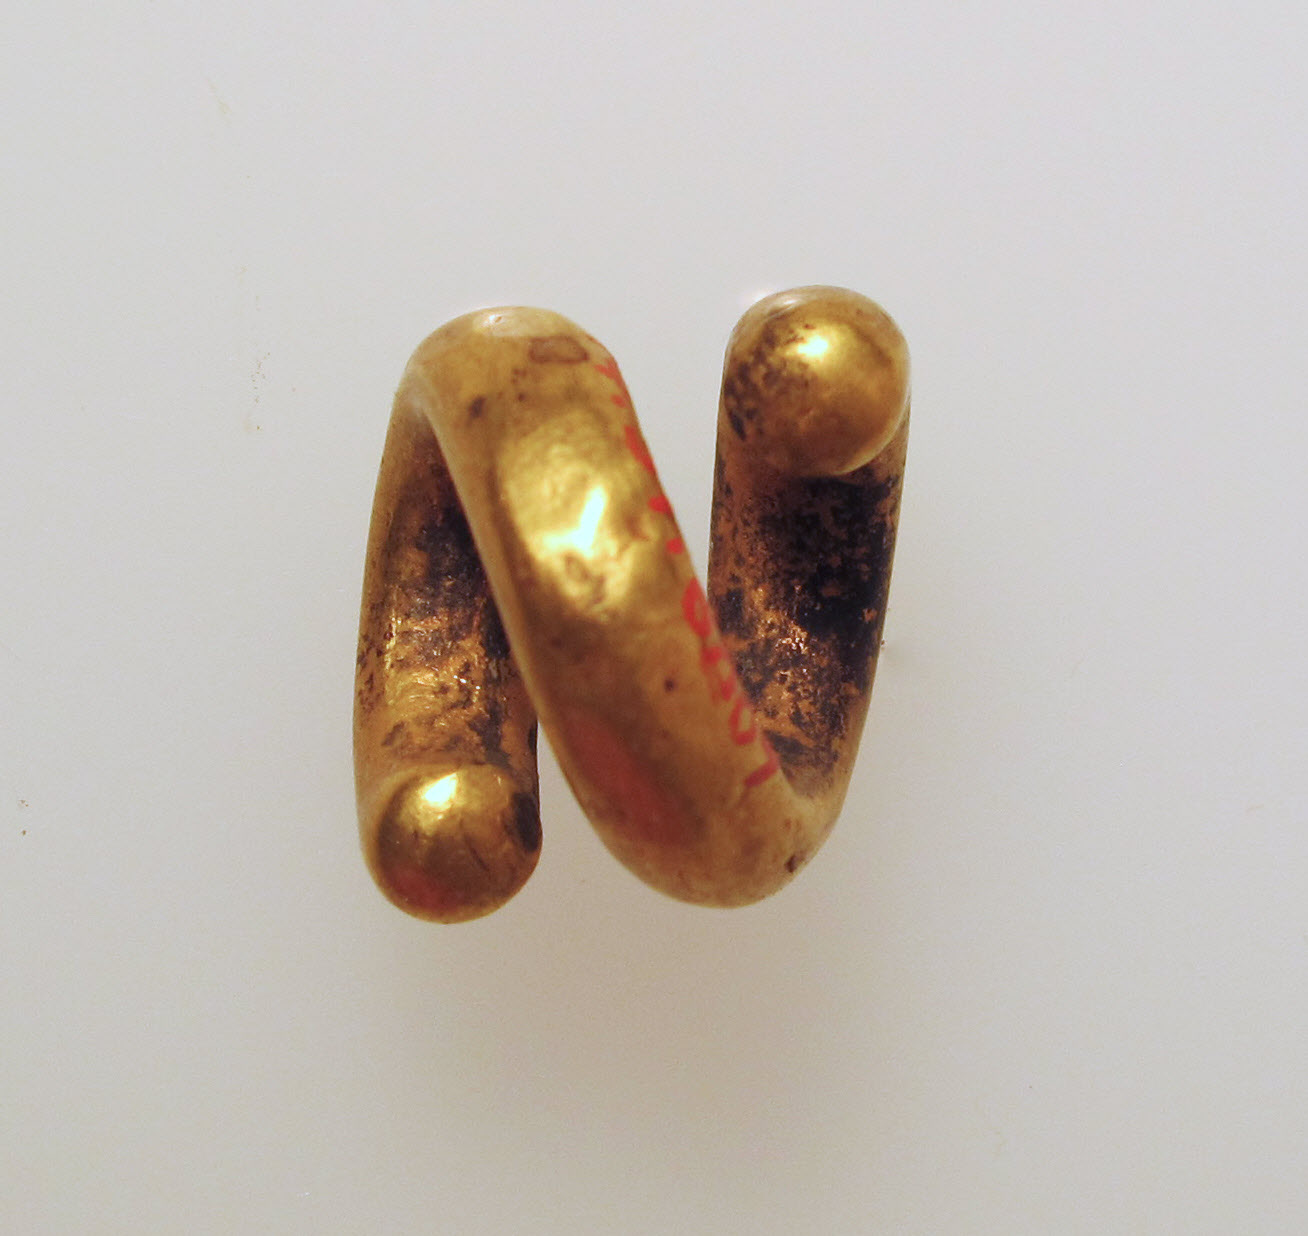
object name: earring or spiral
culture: cypriot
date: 500-401 BCE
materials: gold